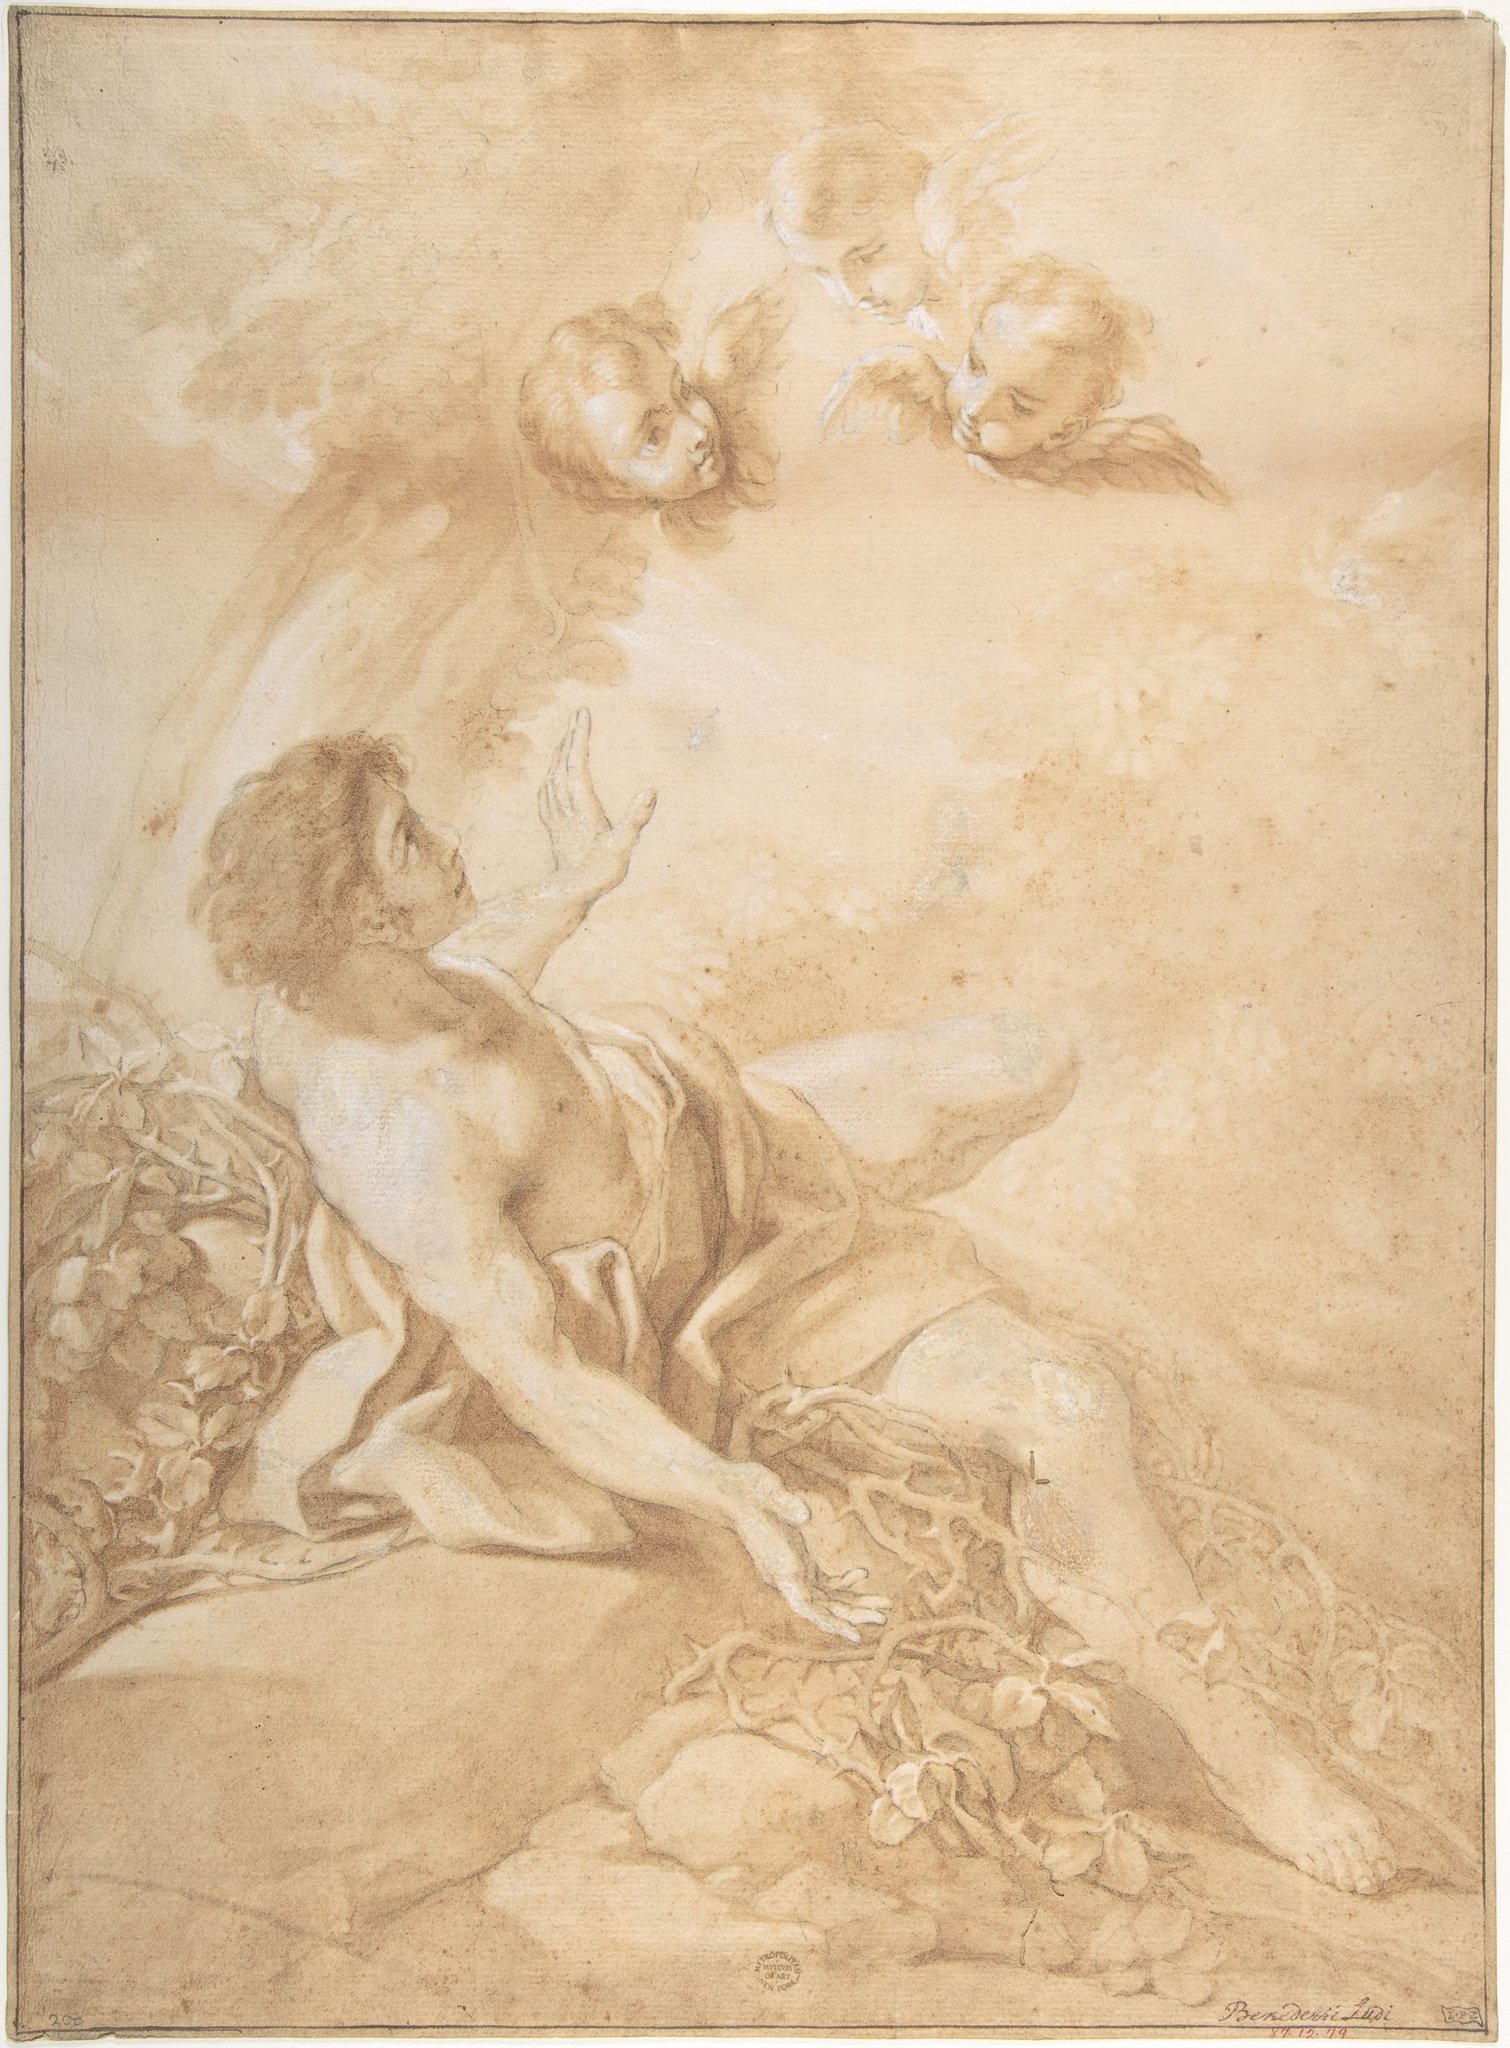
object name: drawing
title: Saint Benedict on a Bed of Thorns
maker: benedetto luti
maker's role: artist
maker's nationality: italian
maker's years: 1666-1724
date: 1666-1724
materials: chalk, paper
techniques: brush, highlighting, wash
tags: men,putti,saints